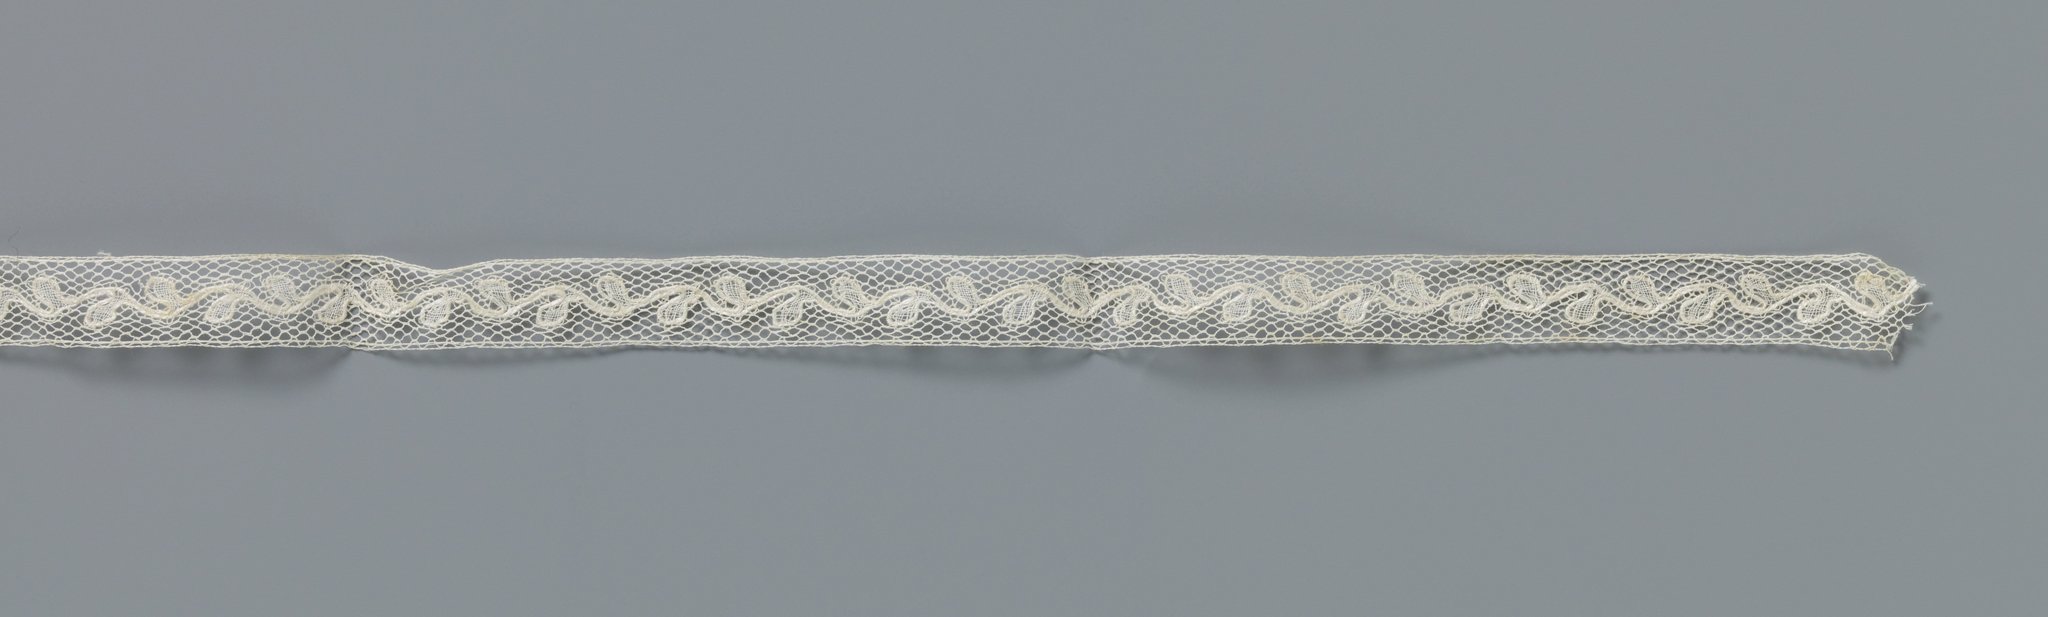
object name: strip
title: Tussenzetsel van machinale kant met druppelvormige blaadjes aan een golvende rank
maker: Anonymous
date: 1800-1899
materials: cotton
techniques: lace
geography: europe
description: Tussenzetsel van machinale kant: machinale Mechelse kant. Het zich herhalende en doorlopende patroon bestaat uit een golvend rankje met afwisselend aan de bovenzijde en onderzijde een druppelvormig blaadje. De rank en blaadjes zijn gemaakt in losgewerkte linnenslag met dikkere en glimmende contourdraden. Het motief is in een traliegrond gemaakt, een machinale Mechelse grond. Boven- en onderzijde van de strook zijn recht afgewerkt. De strook is op een blauw kaartje gewikkeld met een prijs aanduiding.